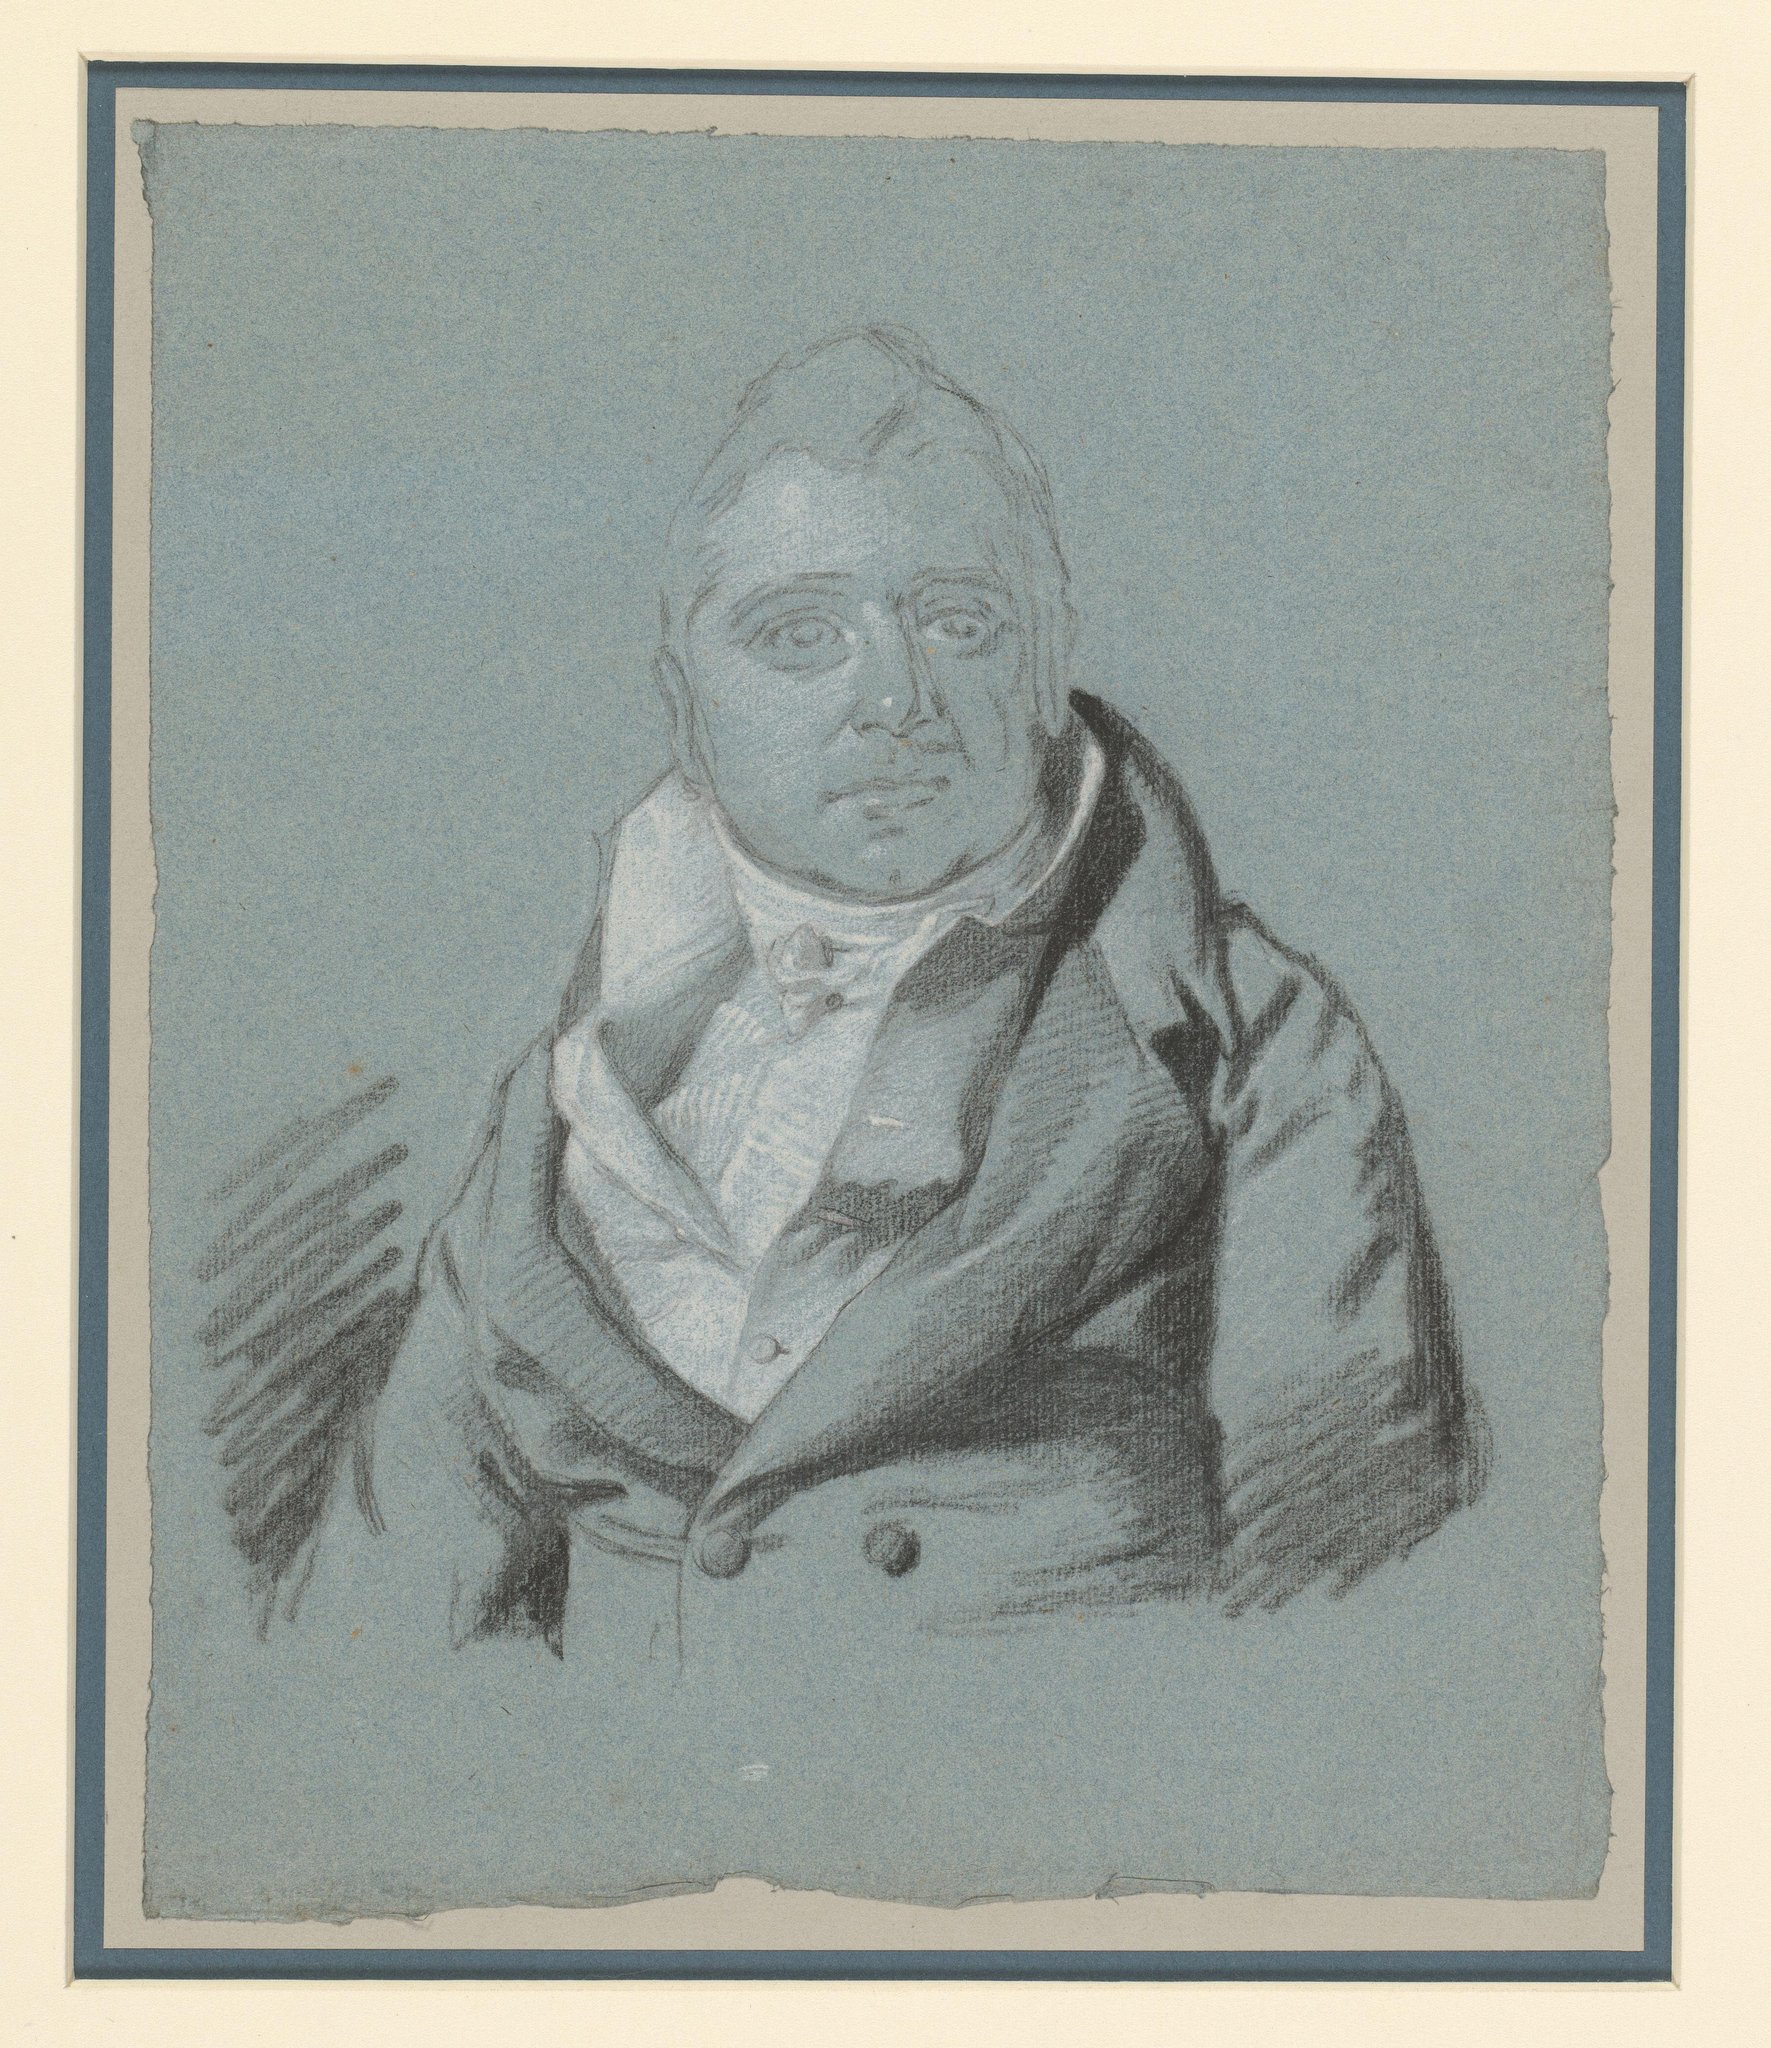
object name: drawing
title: Portret van onbekende heer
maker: charles howard hodges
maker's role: draughtsman, painter, print maker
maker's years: 1764-1837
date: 1774-1837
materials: chalk, paper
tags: anonymous historical person portrayed alone